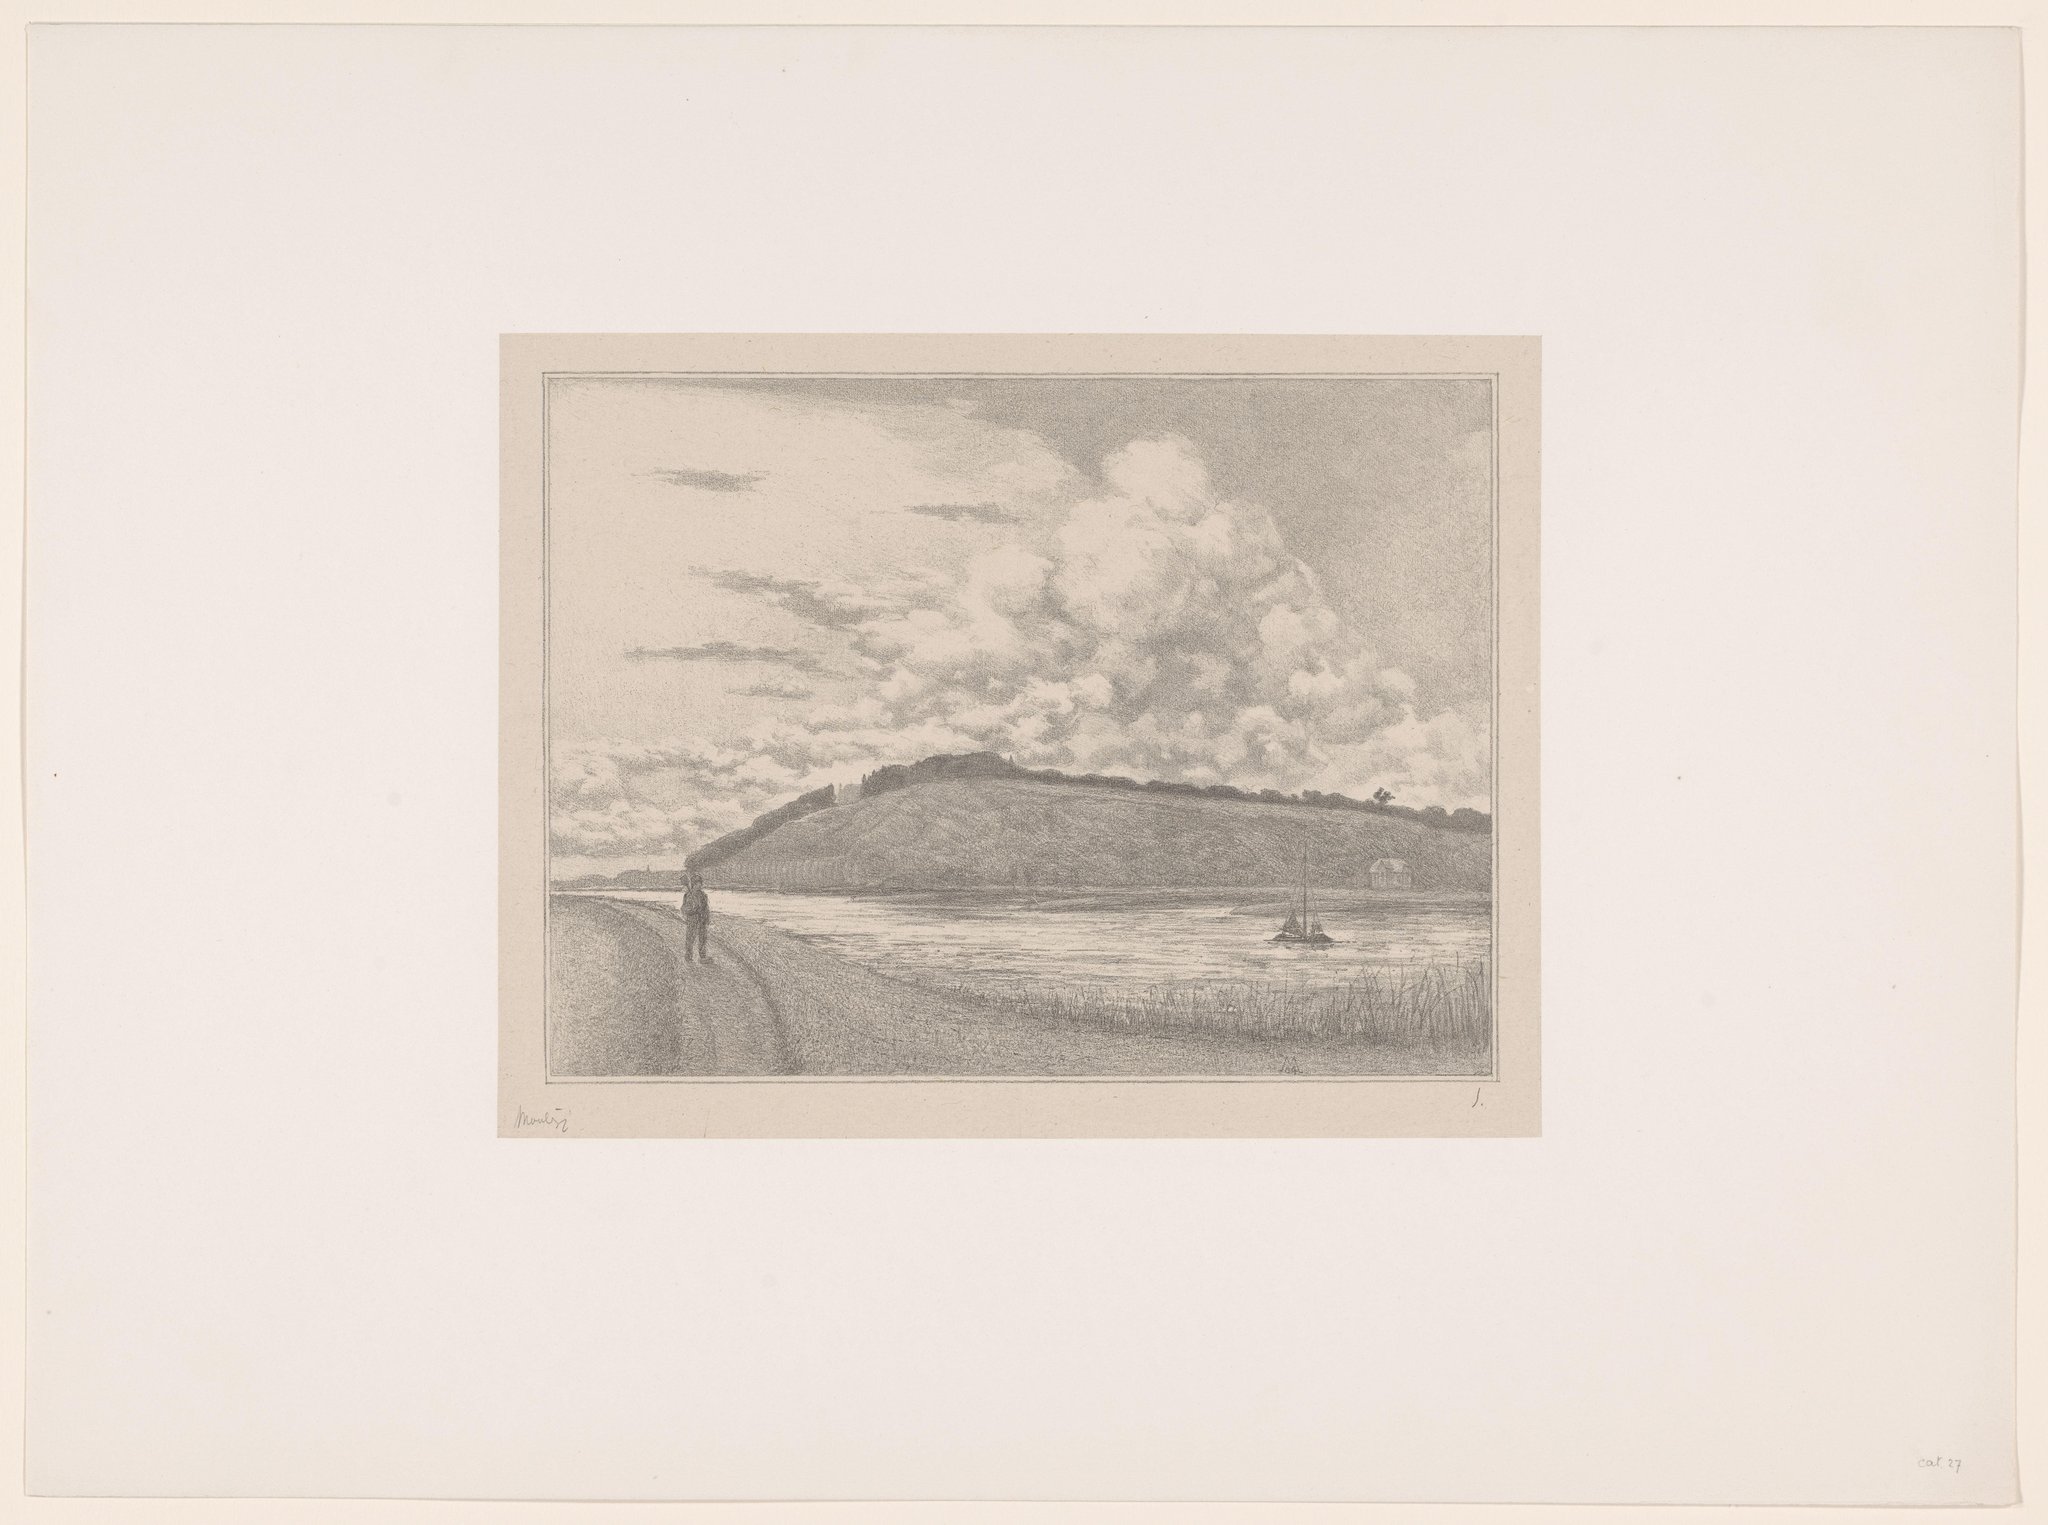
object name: print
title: Gezicht op de Duno van het Drielse Veer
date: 1904-1905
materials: paper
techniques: lithograph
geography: doorwerth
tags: low hill country, river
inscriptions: collector's mark: Lugt 2228